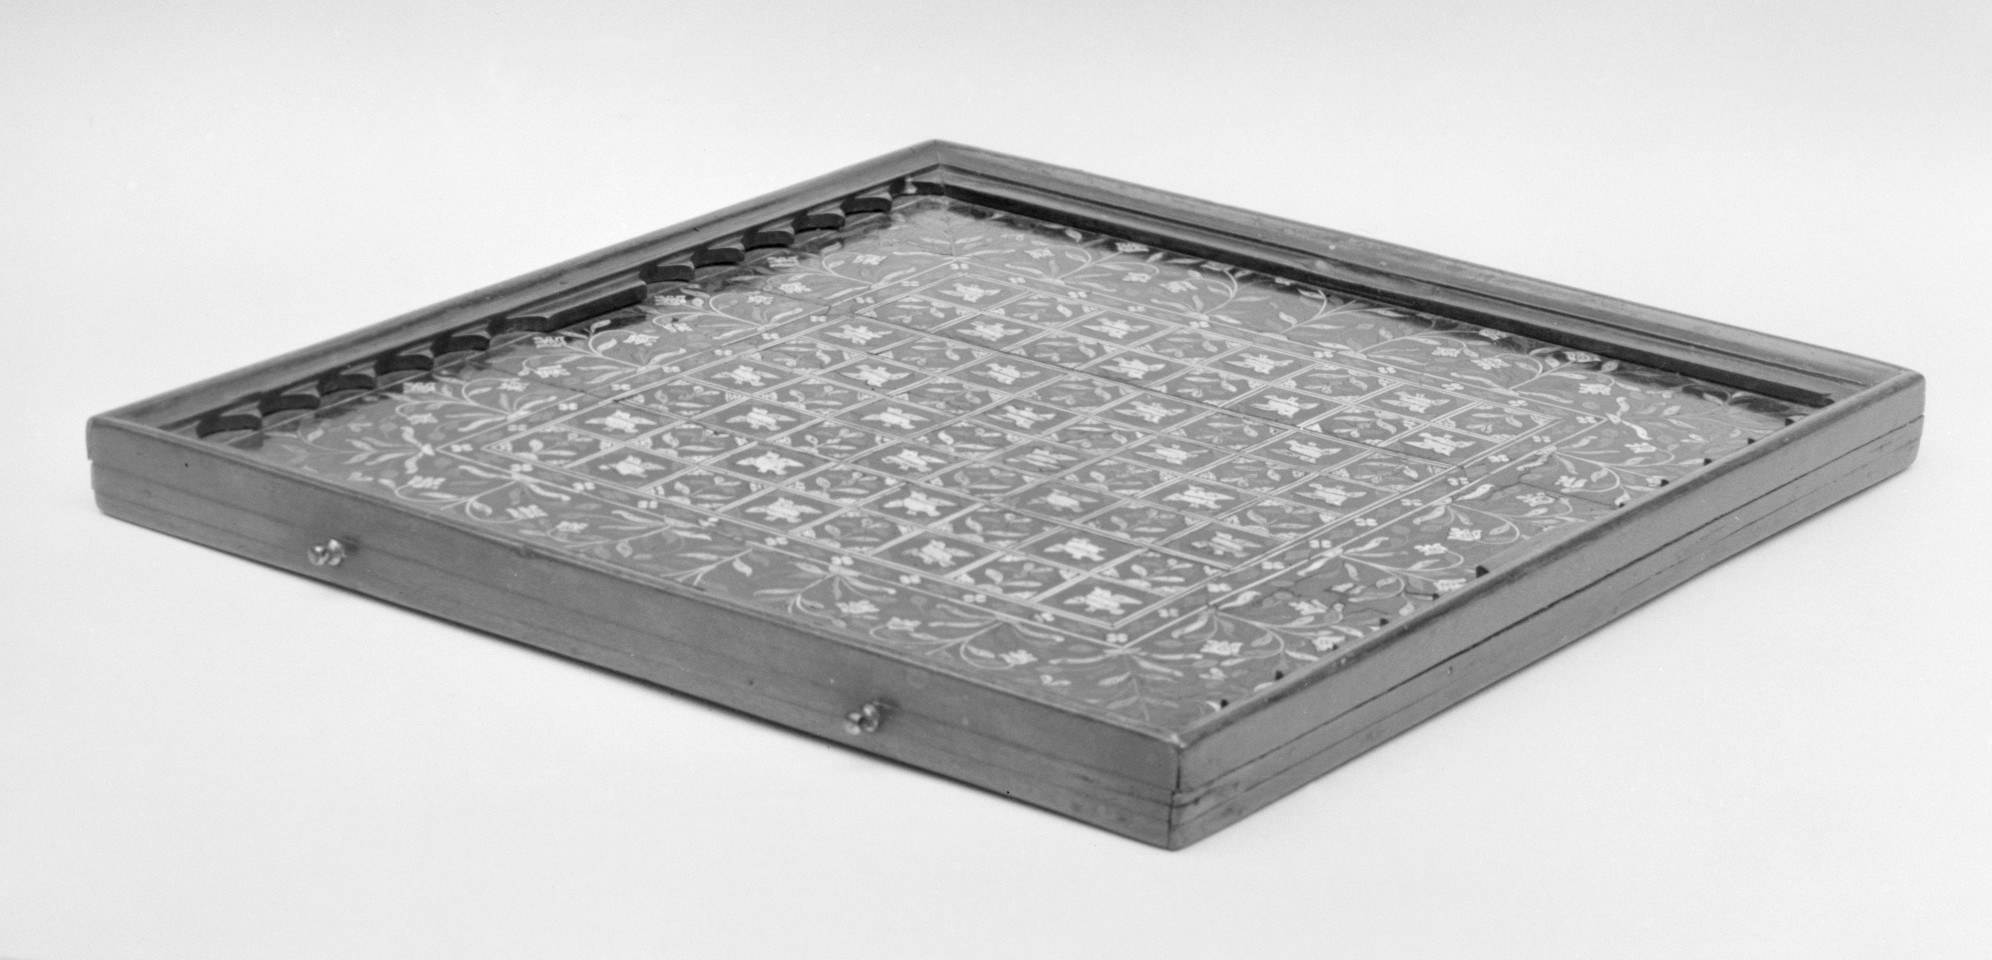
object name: chessboard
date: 1601-1800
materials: wood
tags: chess